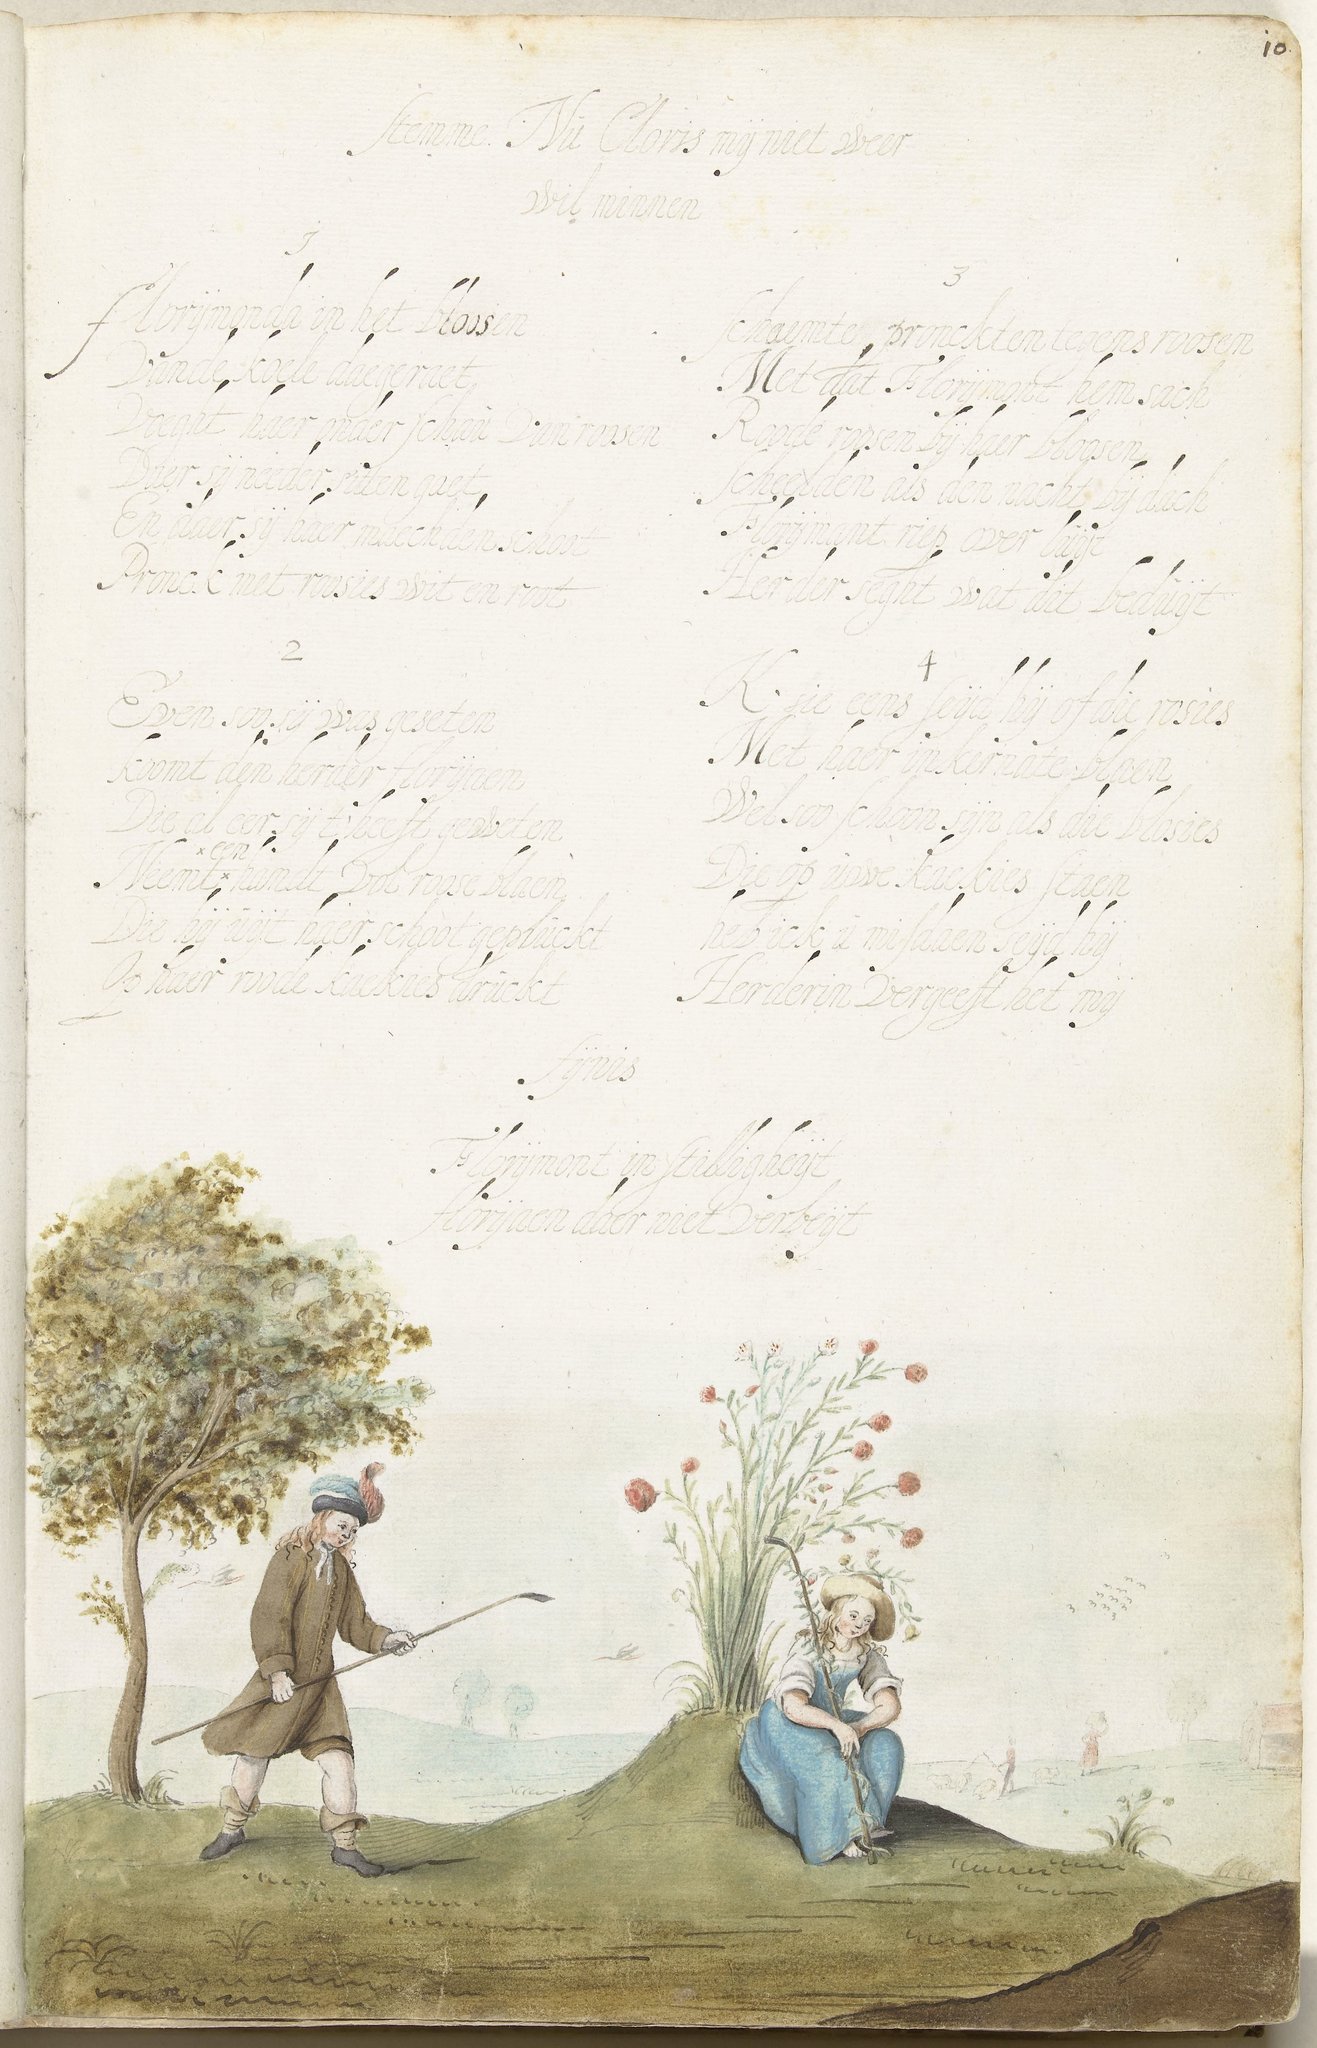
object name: calligraphy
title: Herderspaar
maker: gesina ter borch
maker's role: draughtsman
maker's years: 1633-1690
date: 1652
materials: ink, paper, watercolor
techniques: brush, calligraphy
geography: zwolle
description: Gedicht van Jan Harmens Krul, eerst gepubliceerd in Minne-Popiens, 1639. Daarbij werd de melodie Rosemond die lag gedoken aangegeven.